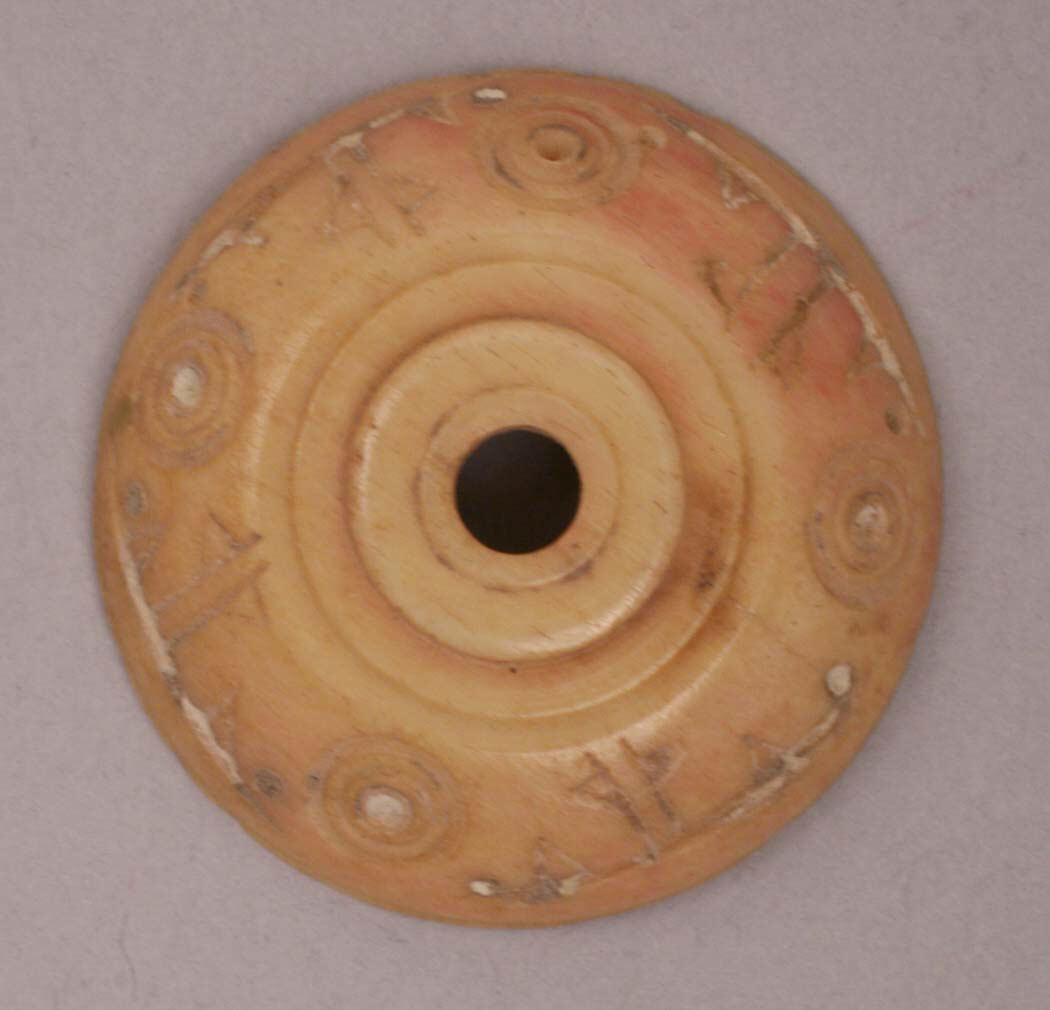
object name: button or spindle whorl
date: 801-1000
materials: bone, paint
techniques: incising, inlay, tinting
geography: iran